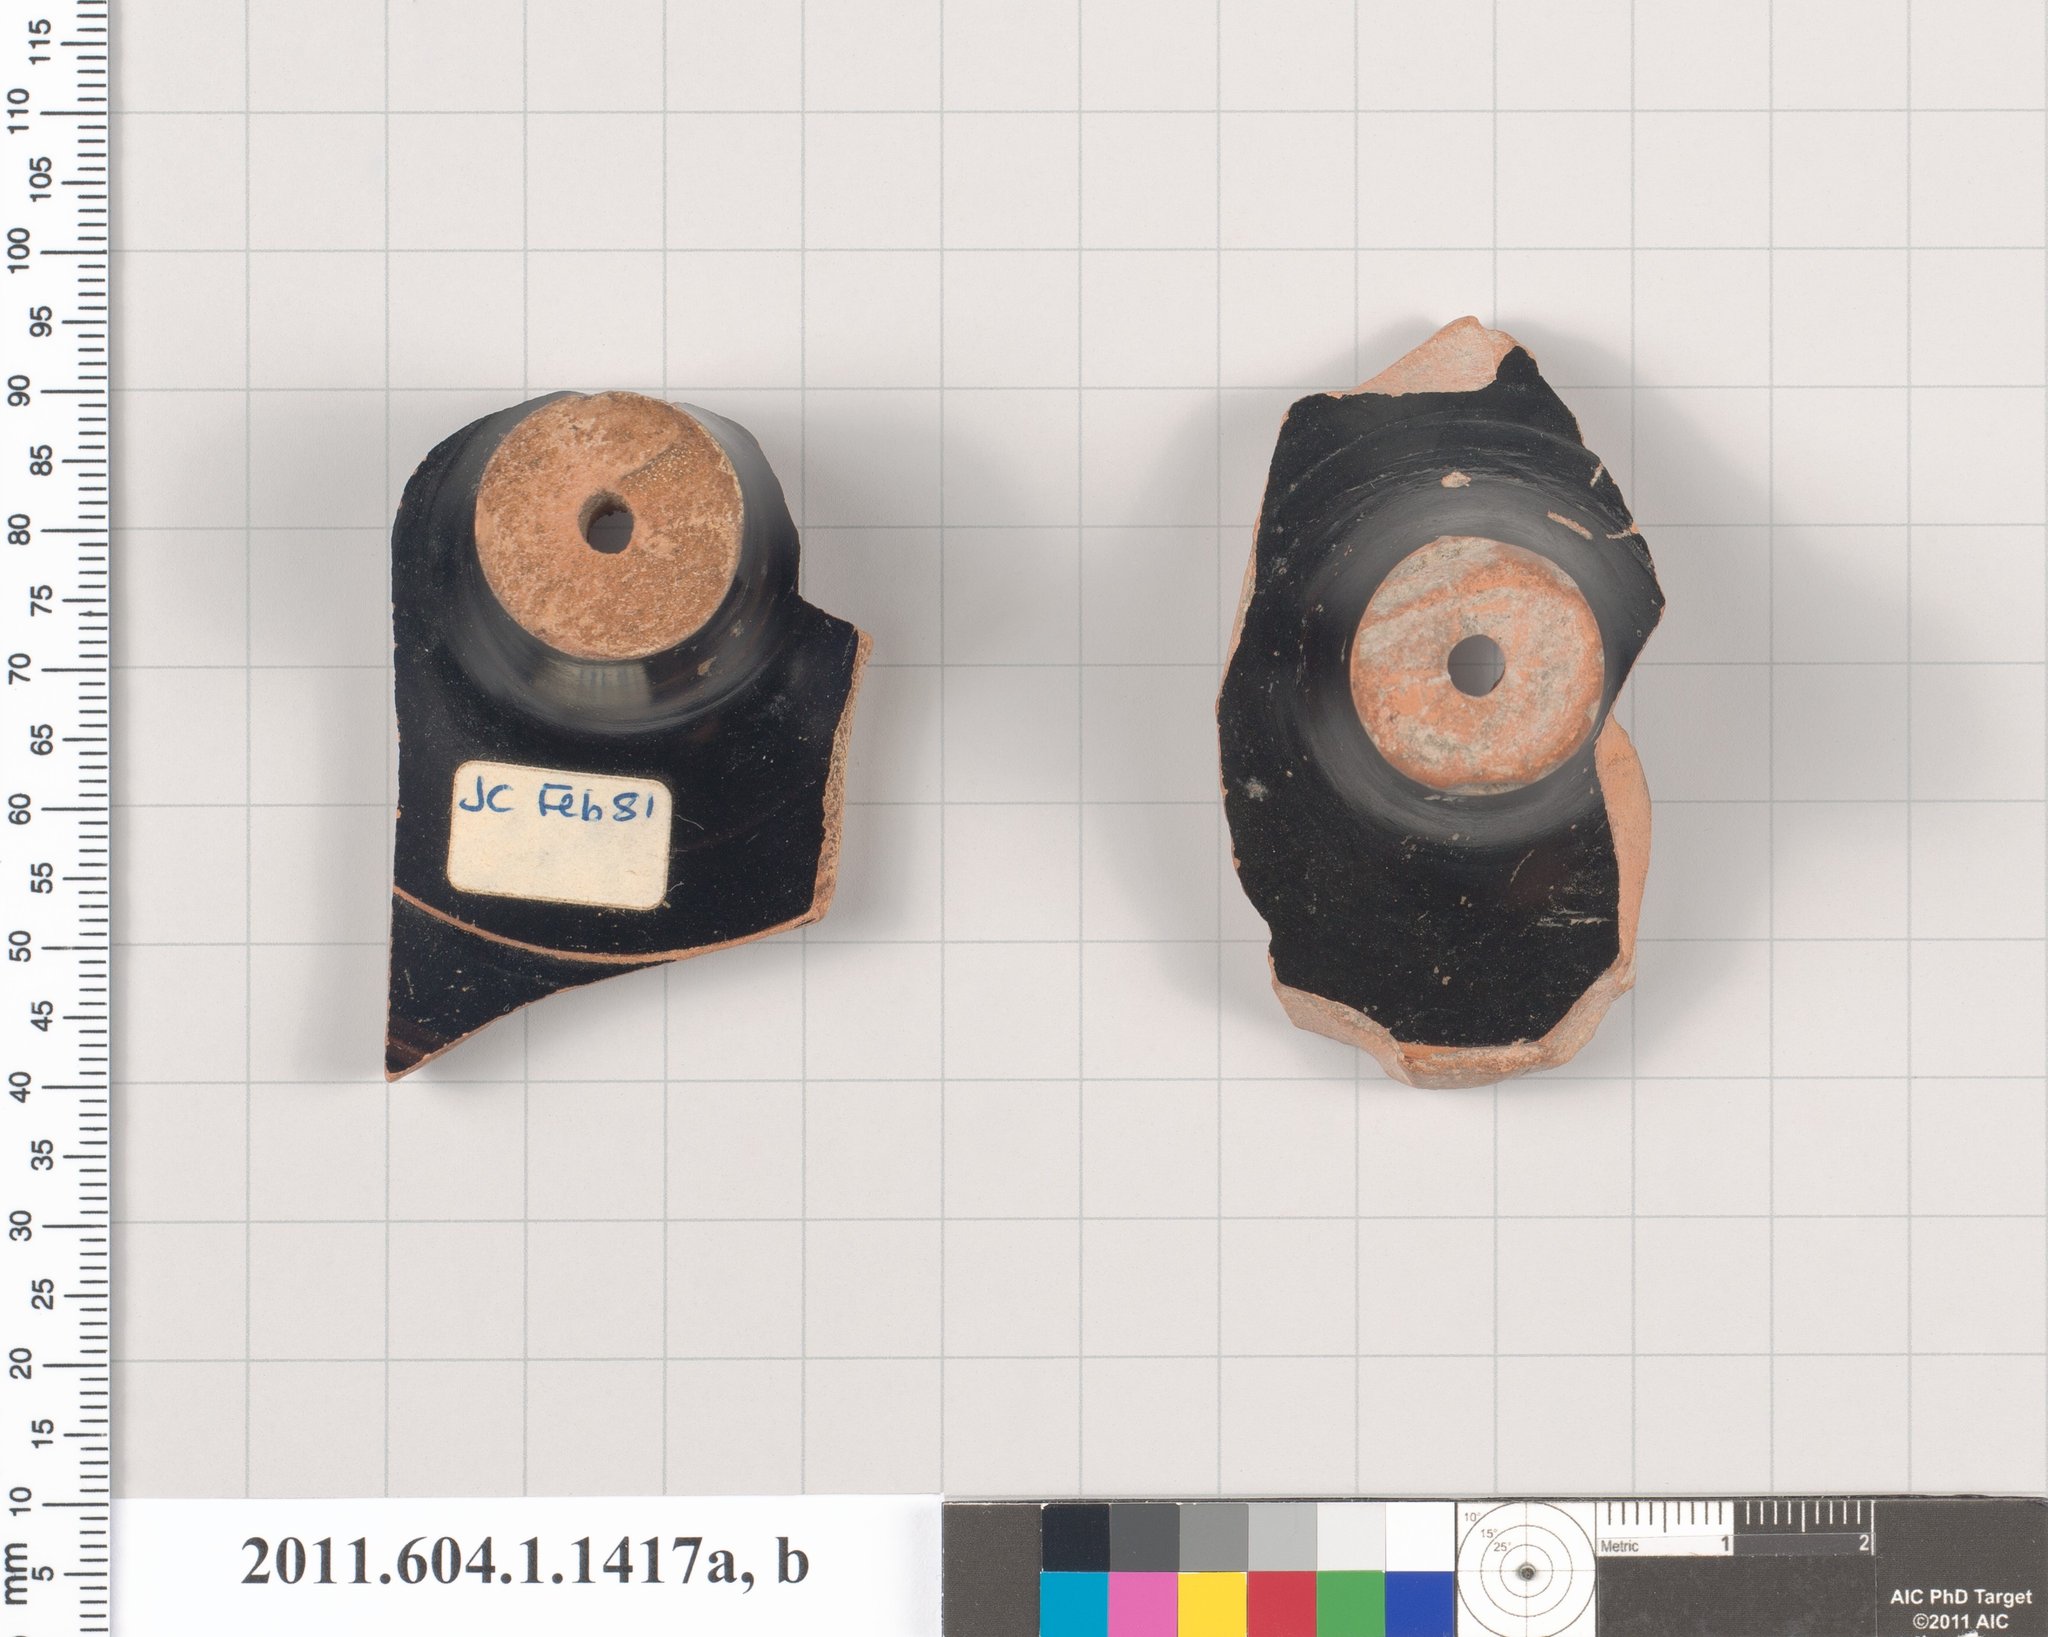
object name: kylix fragment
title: Terracotta fragments of kylikes (drinking cups)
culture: greek, attic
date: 500-401 BCE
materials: terracotta